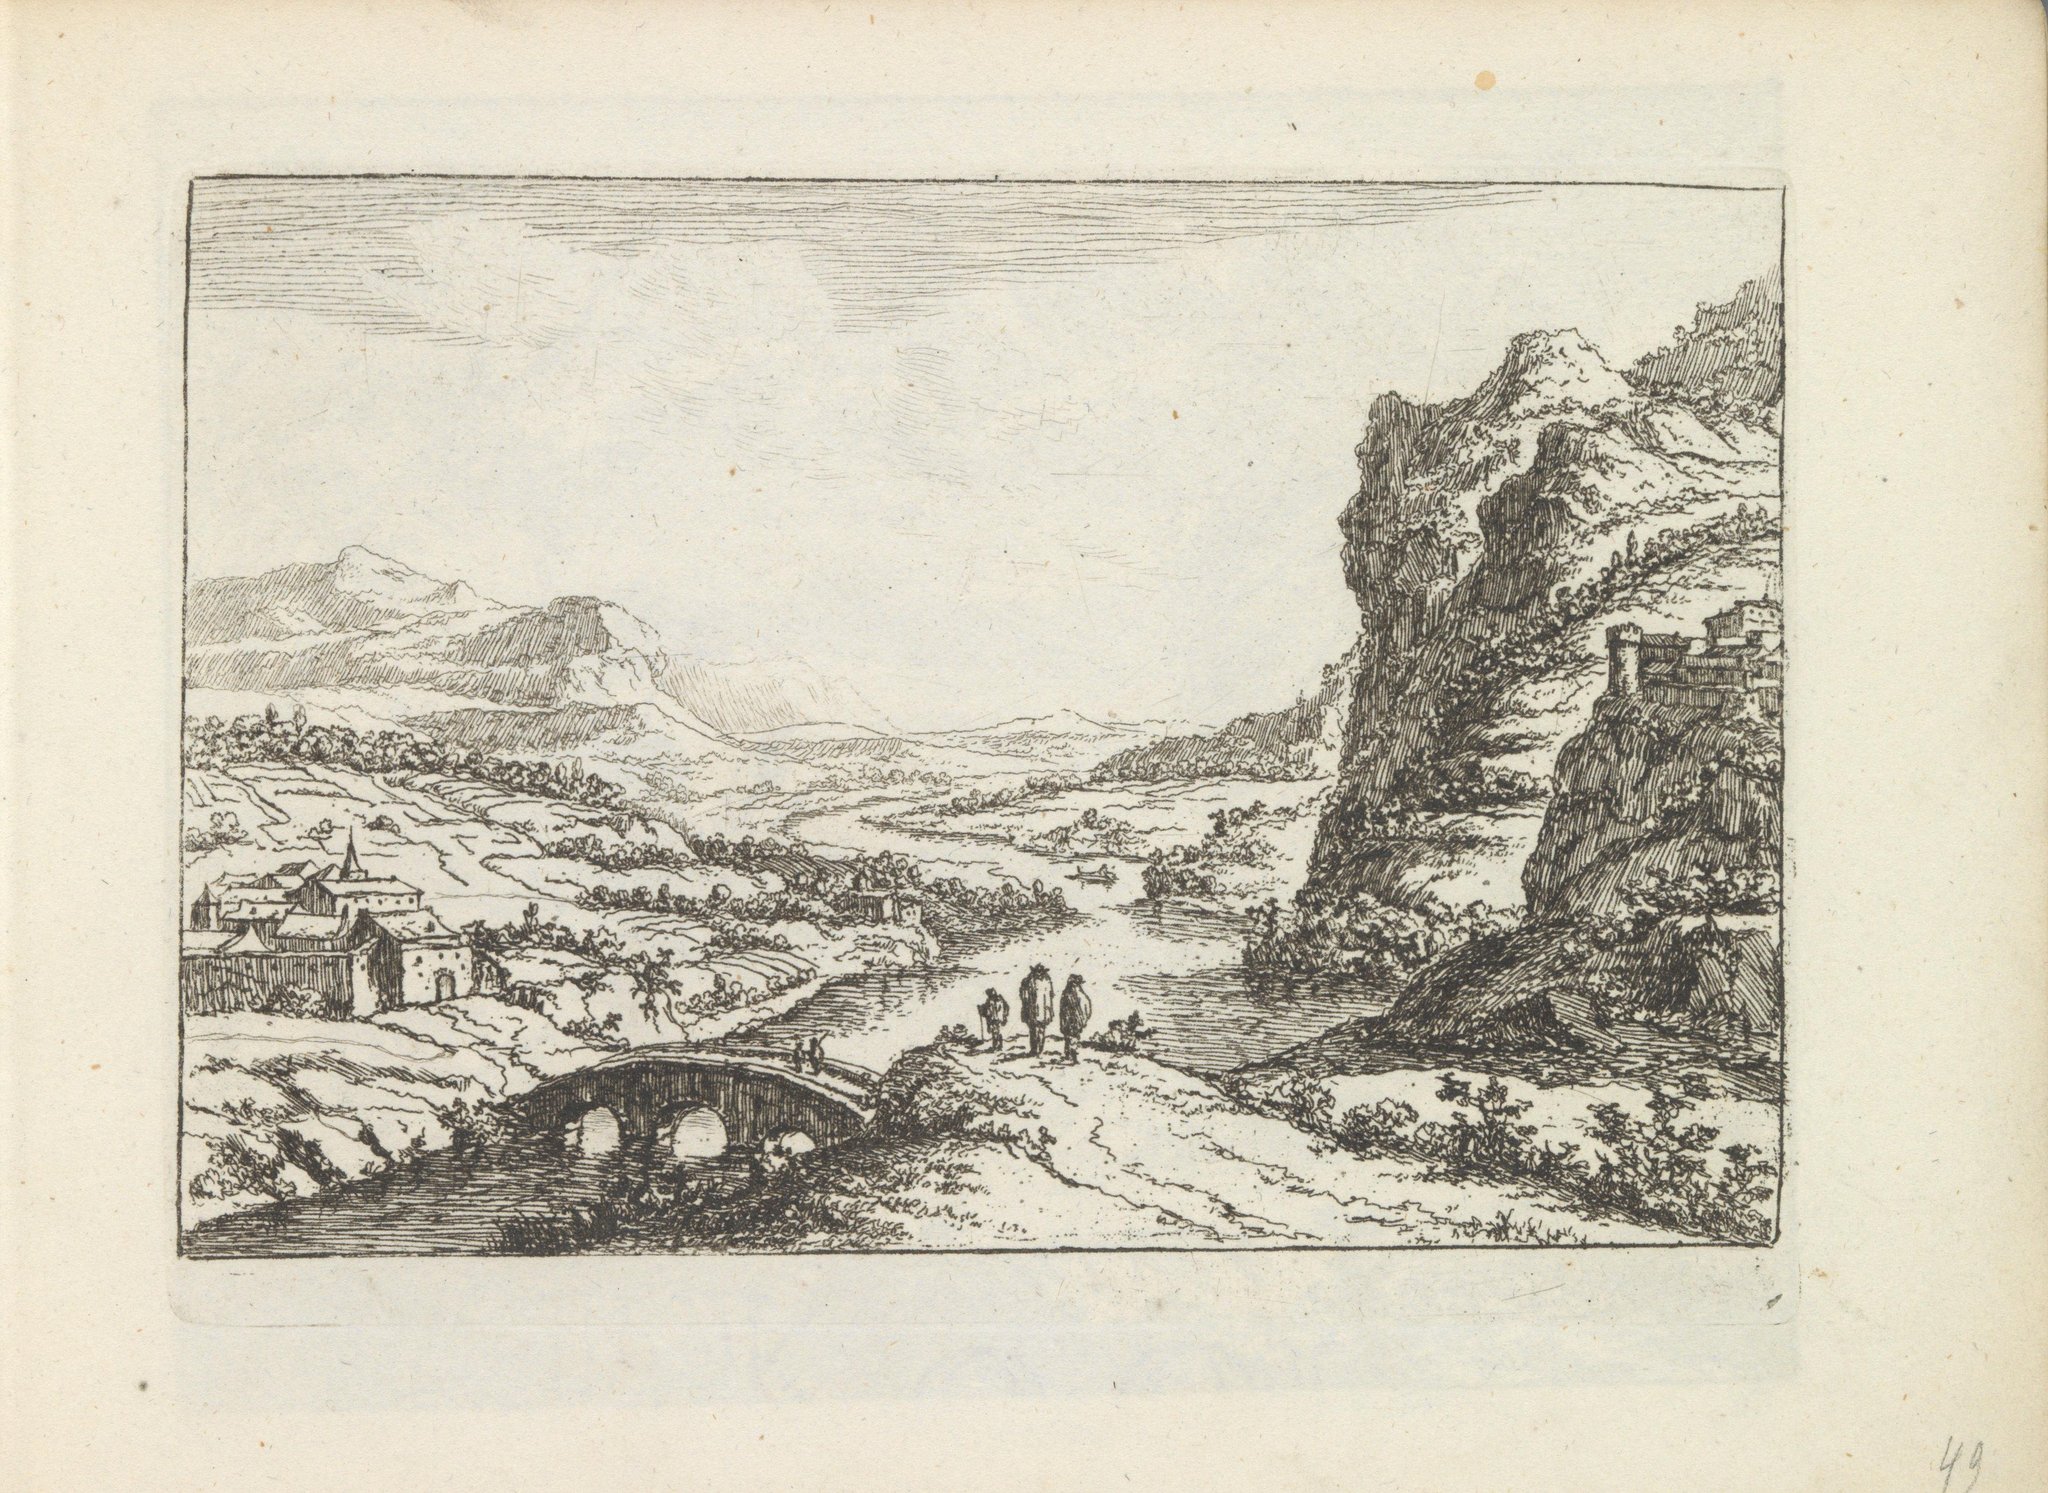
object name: album leaf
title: Spiegel der natuur en school der teekenkunde (...)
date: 1662-1683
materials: paper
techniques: etching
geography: amsterdam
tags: landscapes, river, landscape with bridge, viaduct or aqueduct - ii - ideal landscapes